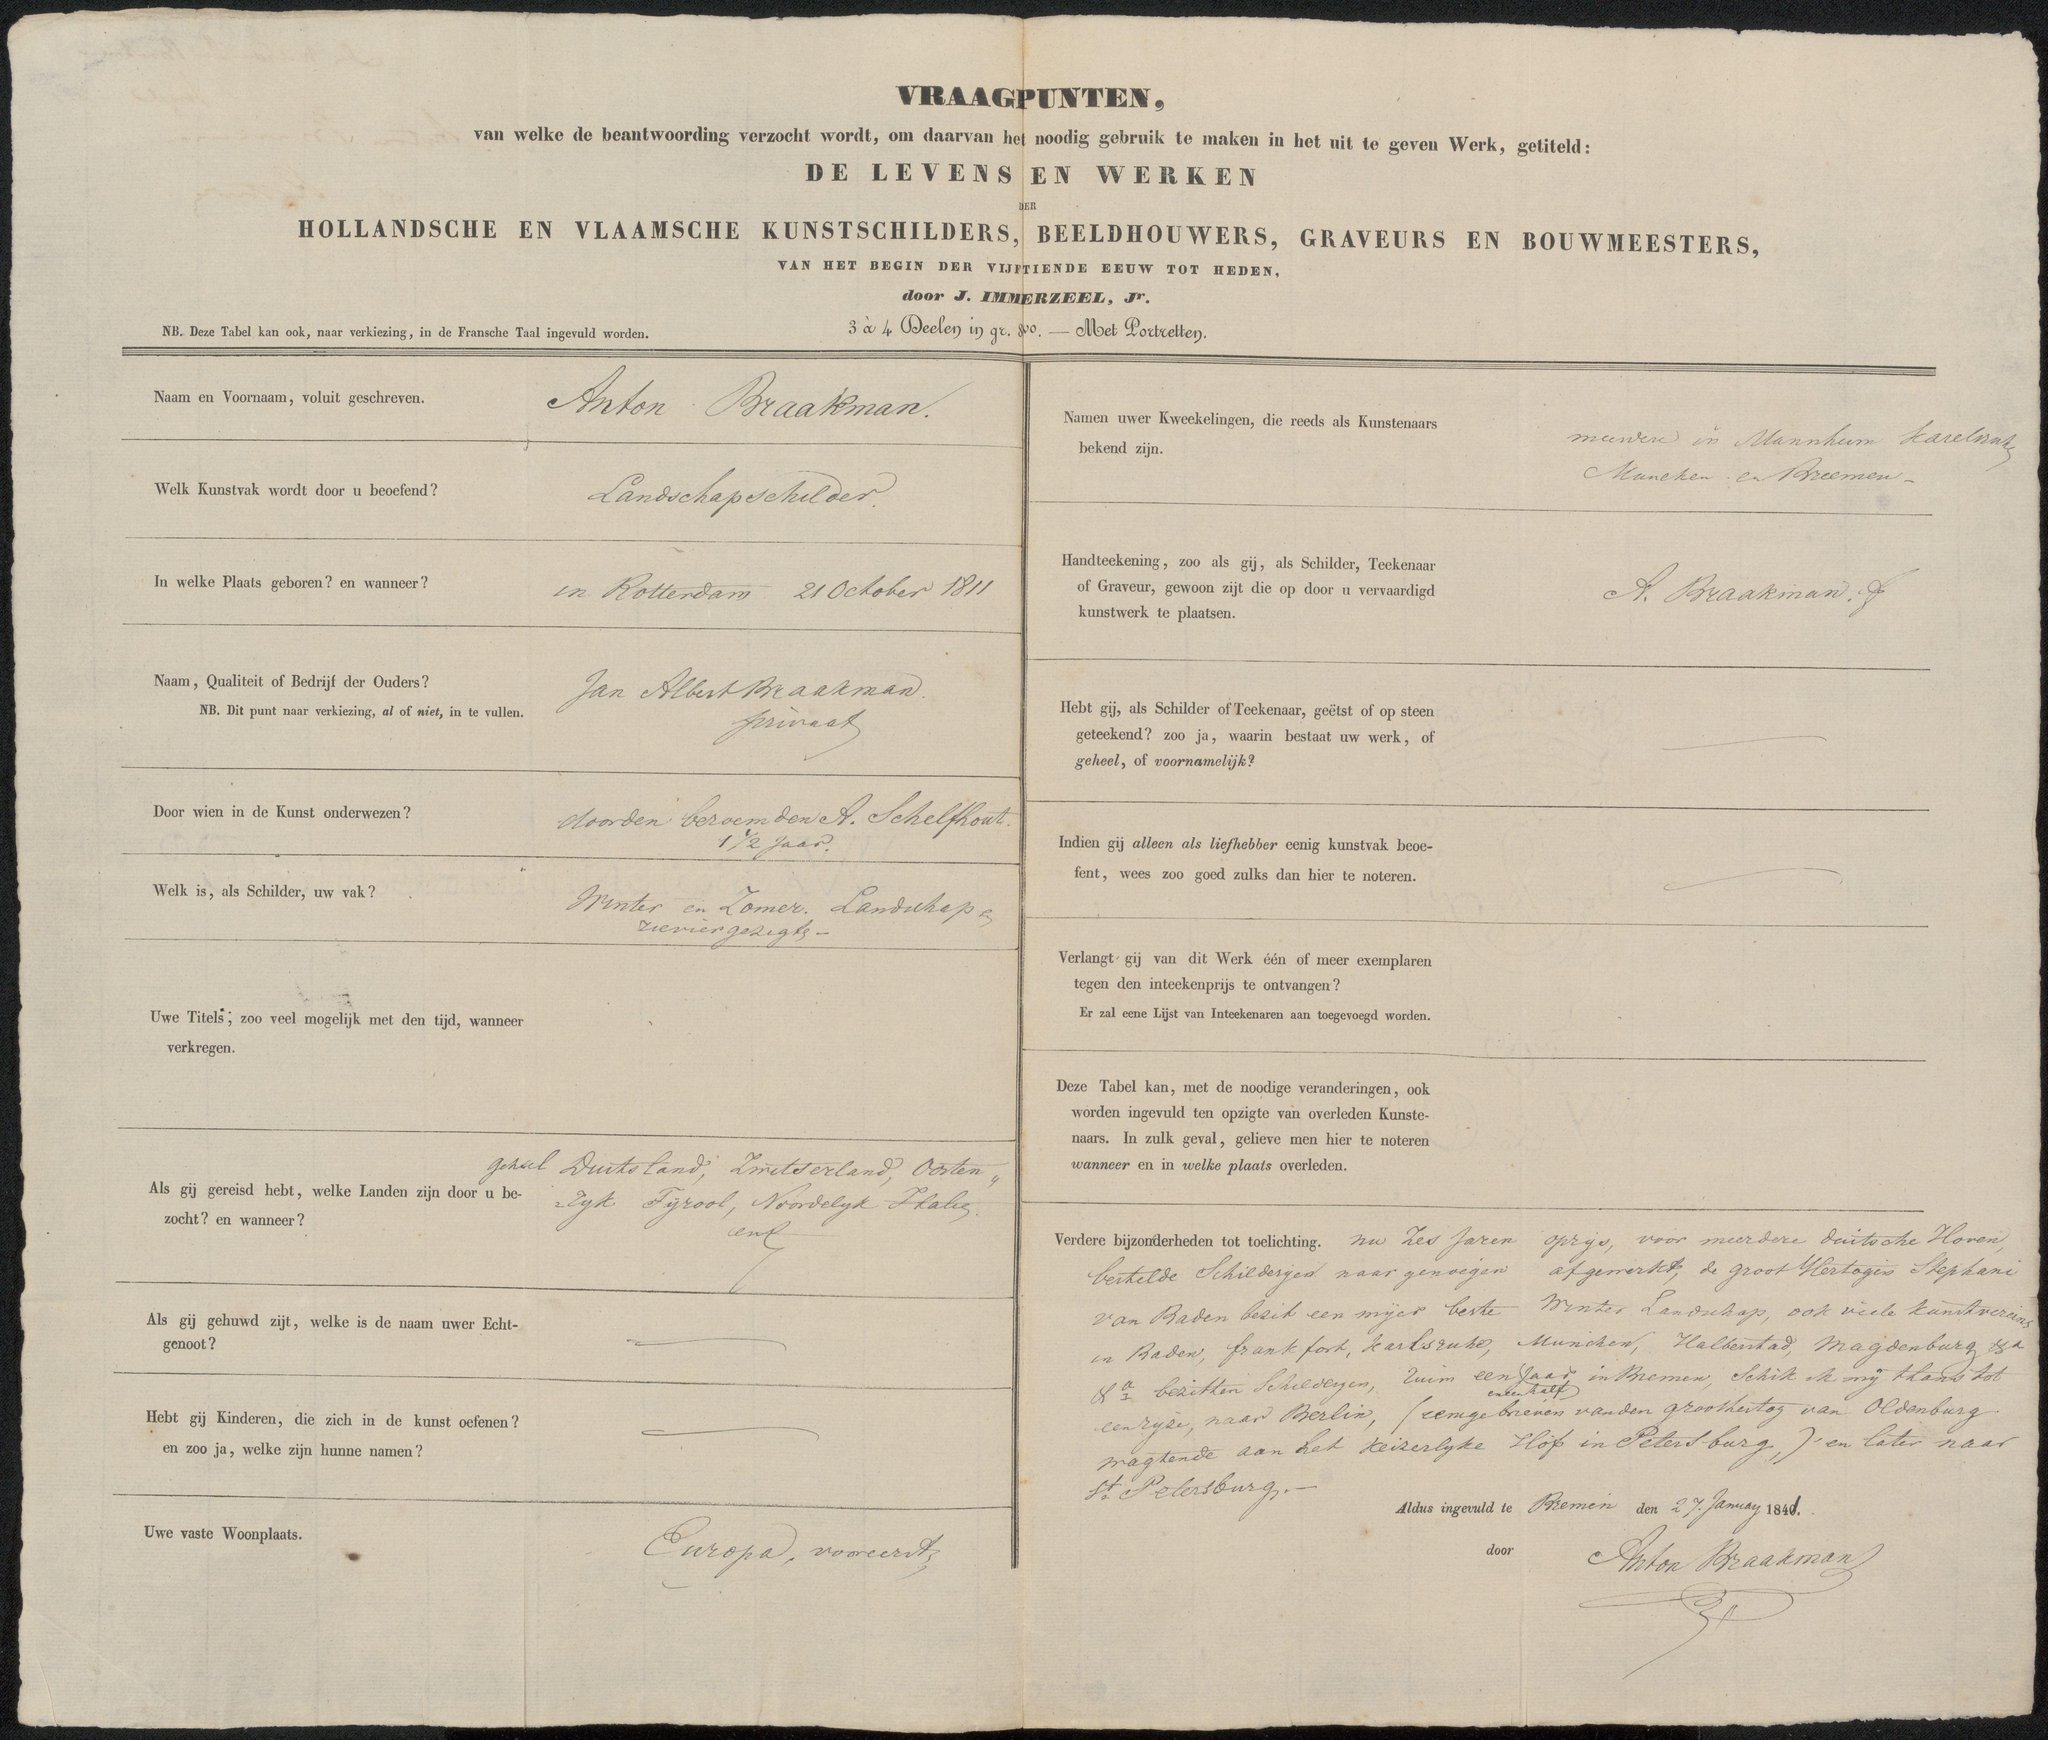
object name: manuscript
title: Enquêteformulier ingevuld door Anton Braakman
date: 1841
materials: ink, paper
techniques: pen, printing, writing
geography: bremen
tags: painter, anton braakman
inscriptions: watermark, inscription: ‘Vraagpunten,/ van welke de beantwoording verzocht wordt, om daarvan het noodig gebruik te maken in het uit te geven Werk, getiteld: De levens en werken/ der Hollandsche en Vlaamsche kunstschilders, beeldhouwers,/ graveurs en bouwmeesters, van het begin der vijftiende eeuw tot heden/ door J. Immerzeel, Jr.’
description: Opgenomen in: Immerzeel, J. Jr., De levens en werken der Hollandsche en Vlaamsche kunstschilders, beeldhouwers, graveurs en bouwmeesters, van het begin der vijftiende eeuw tot heden, Amsterdam: J.C. van Kesteren, 1842-1843.